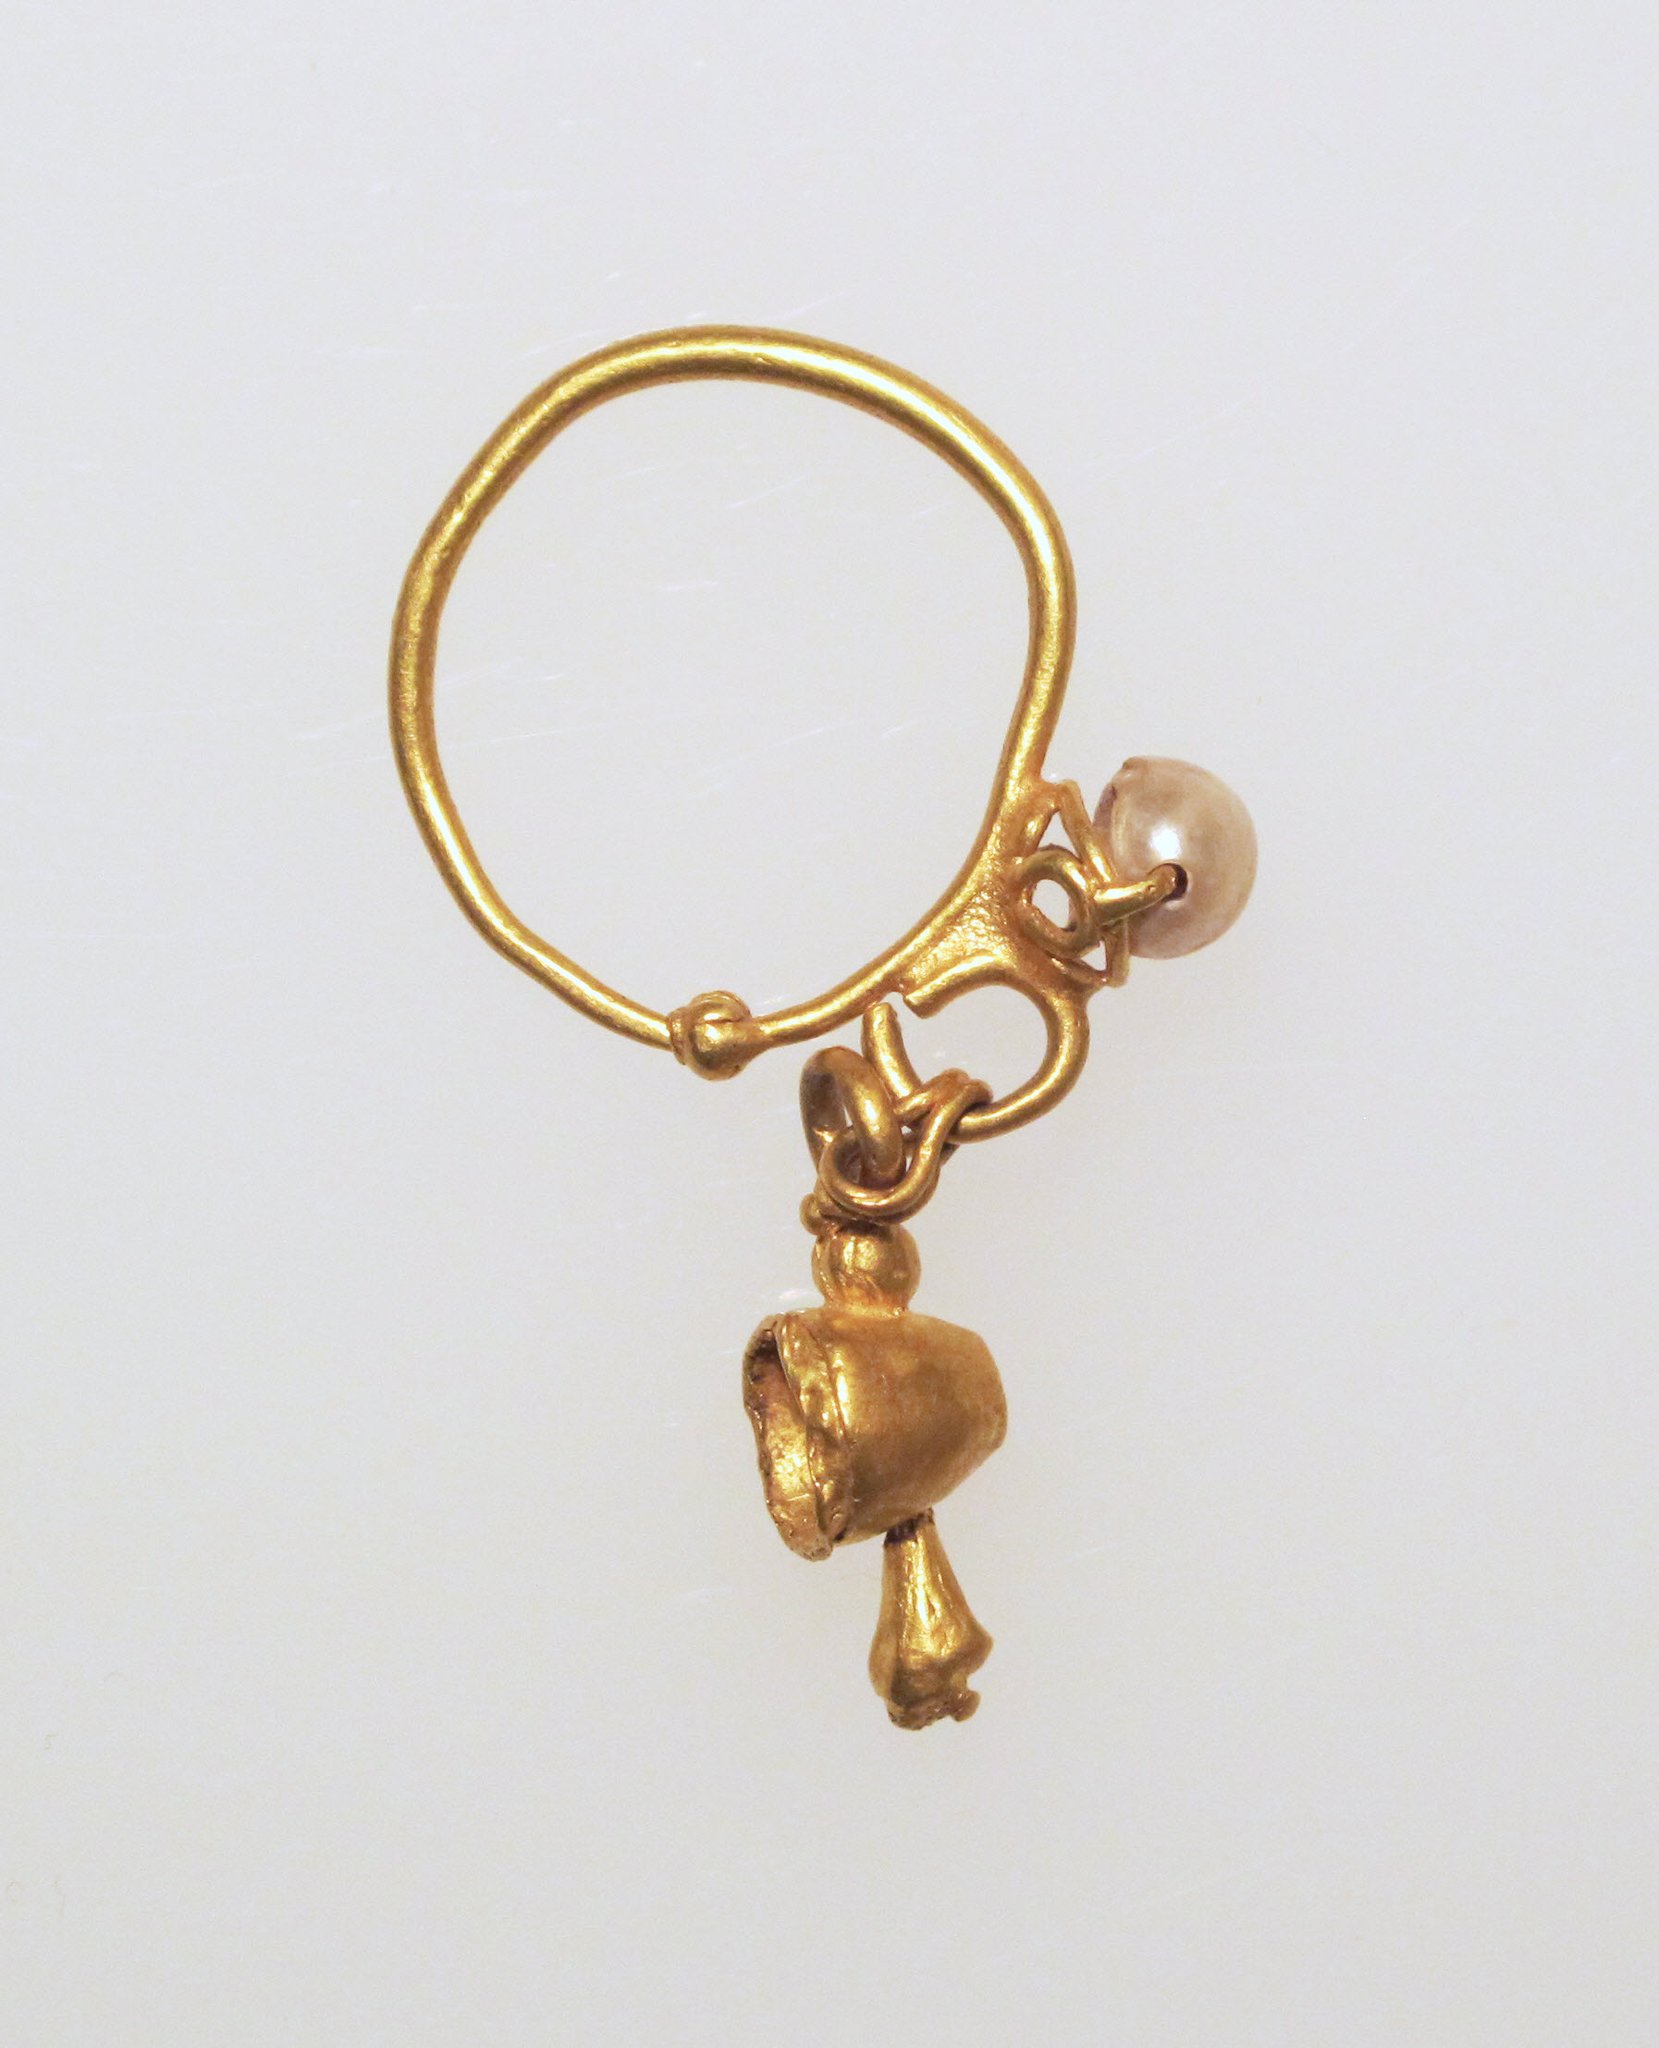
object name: earring with pendant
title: Earring with pendant and pearl setting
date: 7000 BCE-330 CE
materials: gold